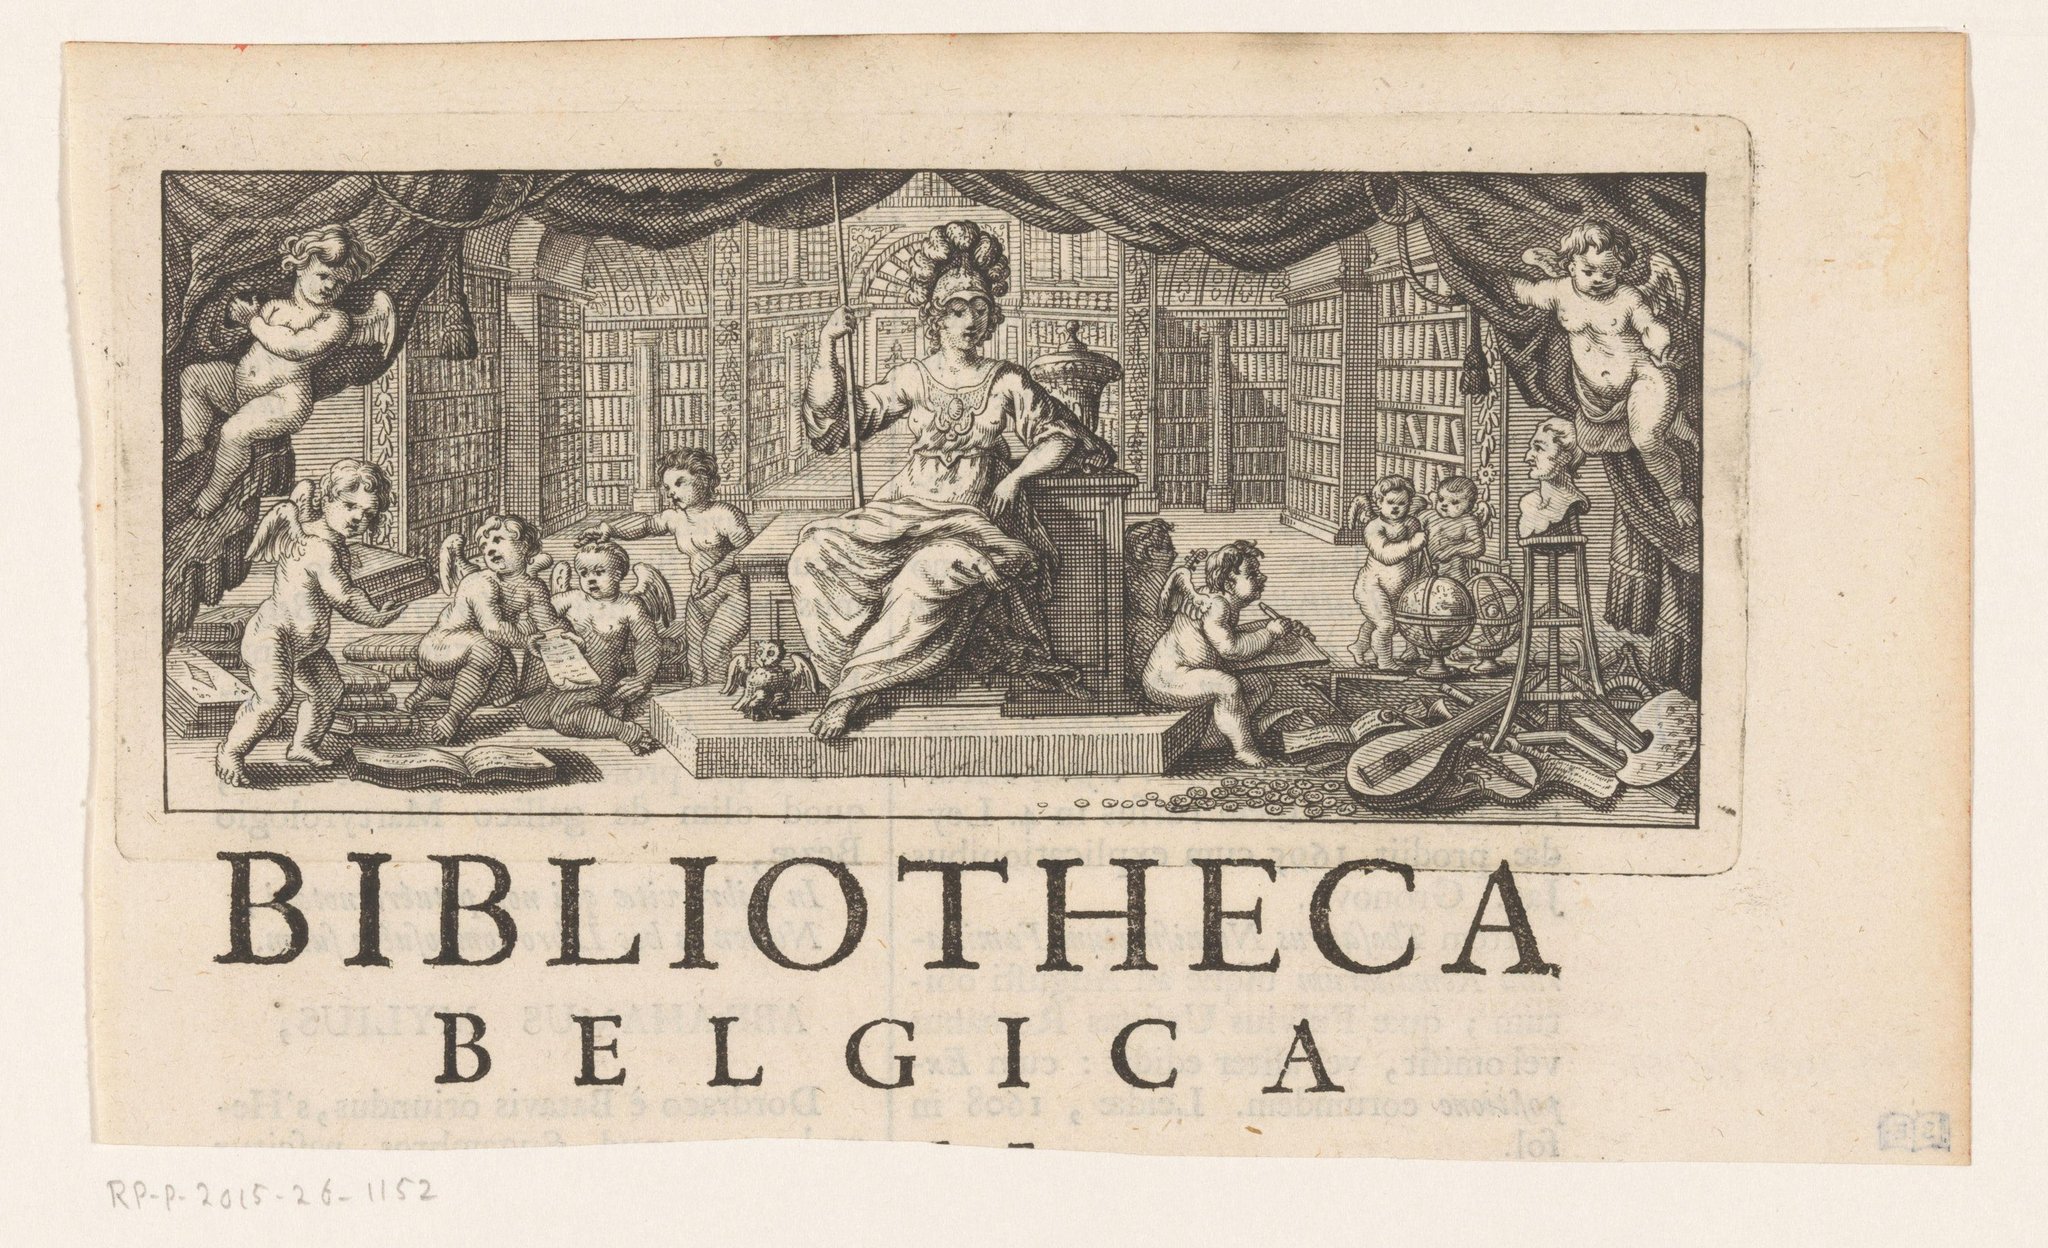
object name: vignette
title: Minerva in een bibliotheek omringd door putti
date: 1739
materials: paper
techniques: etching, letterpress printing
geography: brussels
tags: musical instruments; group of musical instruments, bookshelves, specific aspects, allegorical aspects of minerva; minerva as patroness, cupids: 'amores', 'amoretti', 'putti'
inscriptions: collector's mark: Lugt 2228, collector's mark: Lugt 4780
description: De putti lezen in boeken, tekenen en meten afstanden op een globe. Rechts op de voorgrond een buste, muziekinstrumenten en een schilderspalet.